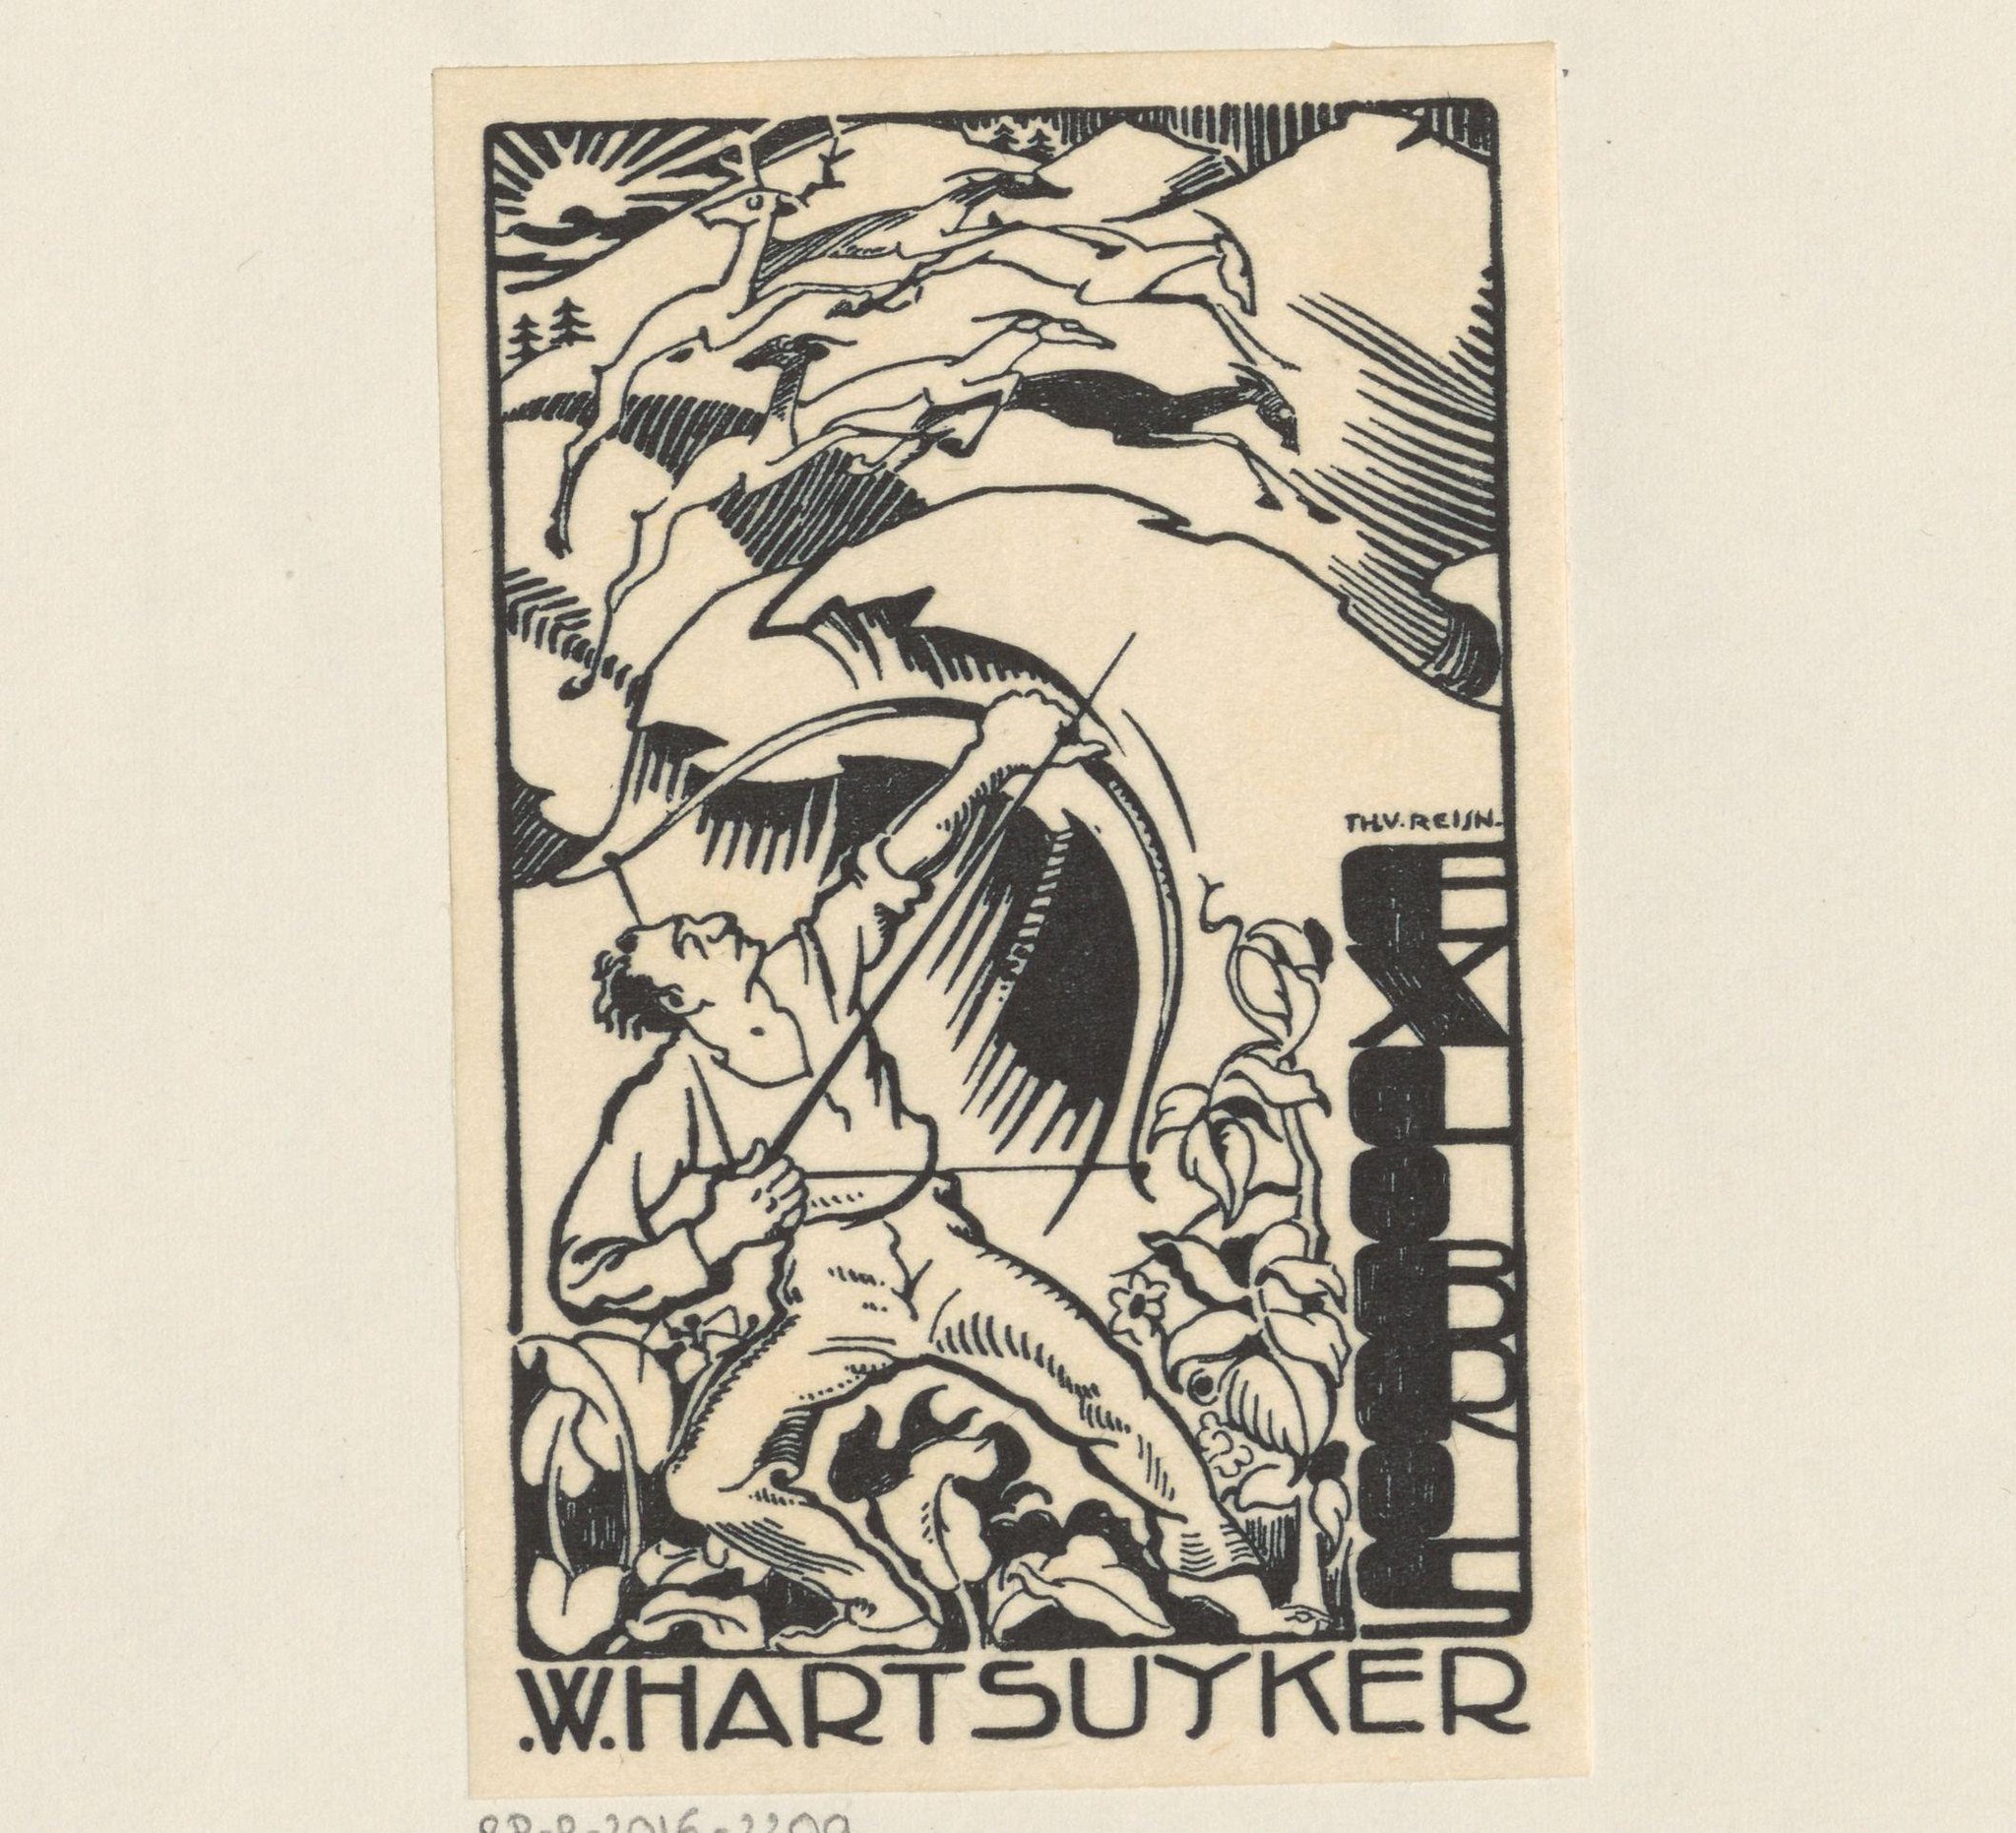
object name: bookplate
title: Ex libris van W. Hartsuyker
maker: theo van reijn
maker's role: draughtsman, print maker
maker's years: 1884-1954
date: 1894-1954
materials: paper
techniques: printing block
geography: netherlands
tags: hoofed animals: deer, hunting, chase, archer's weapons